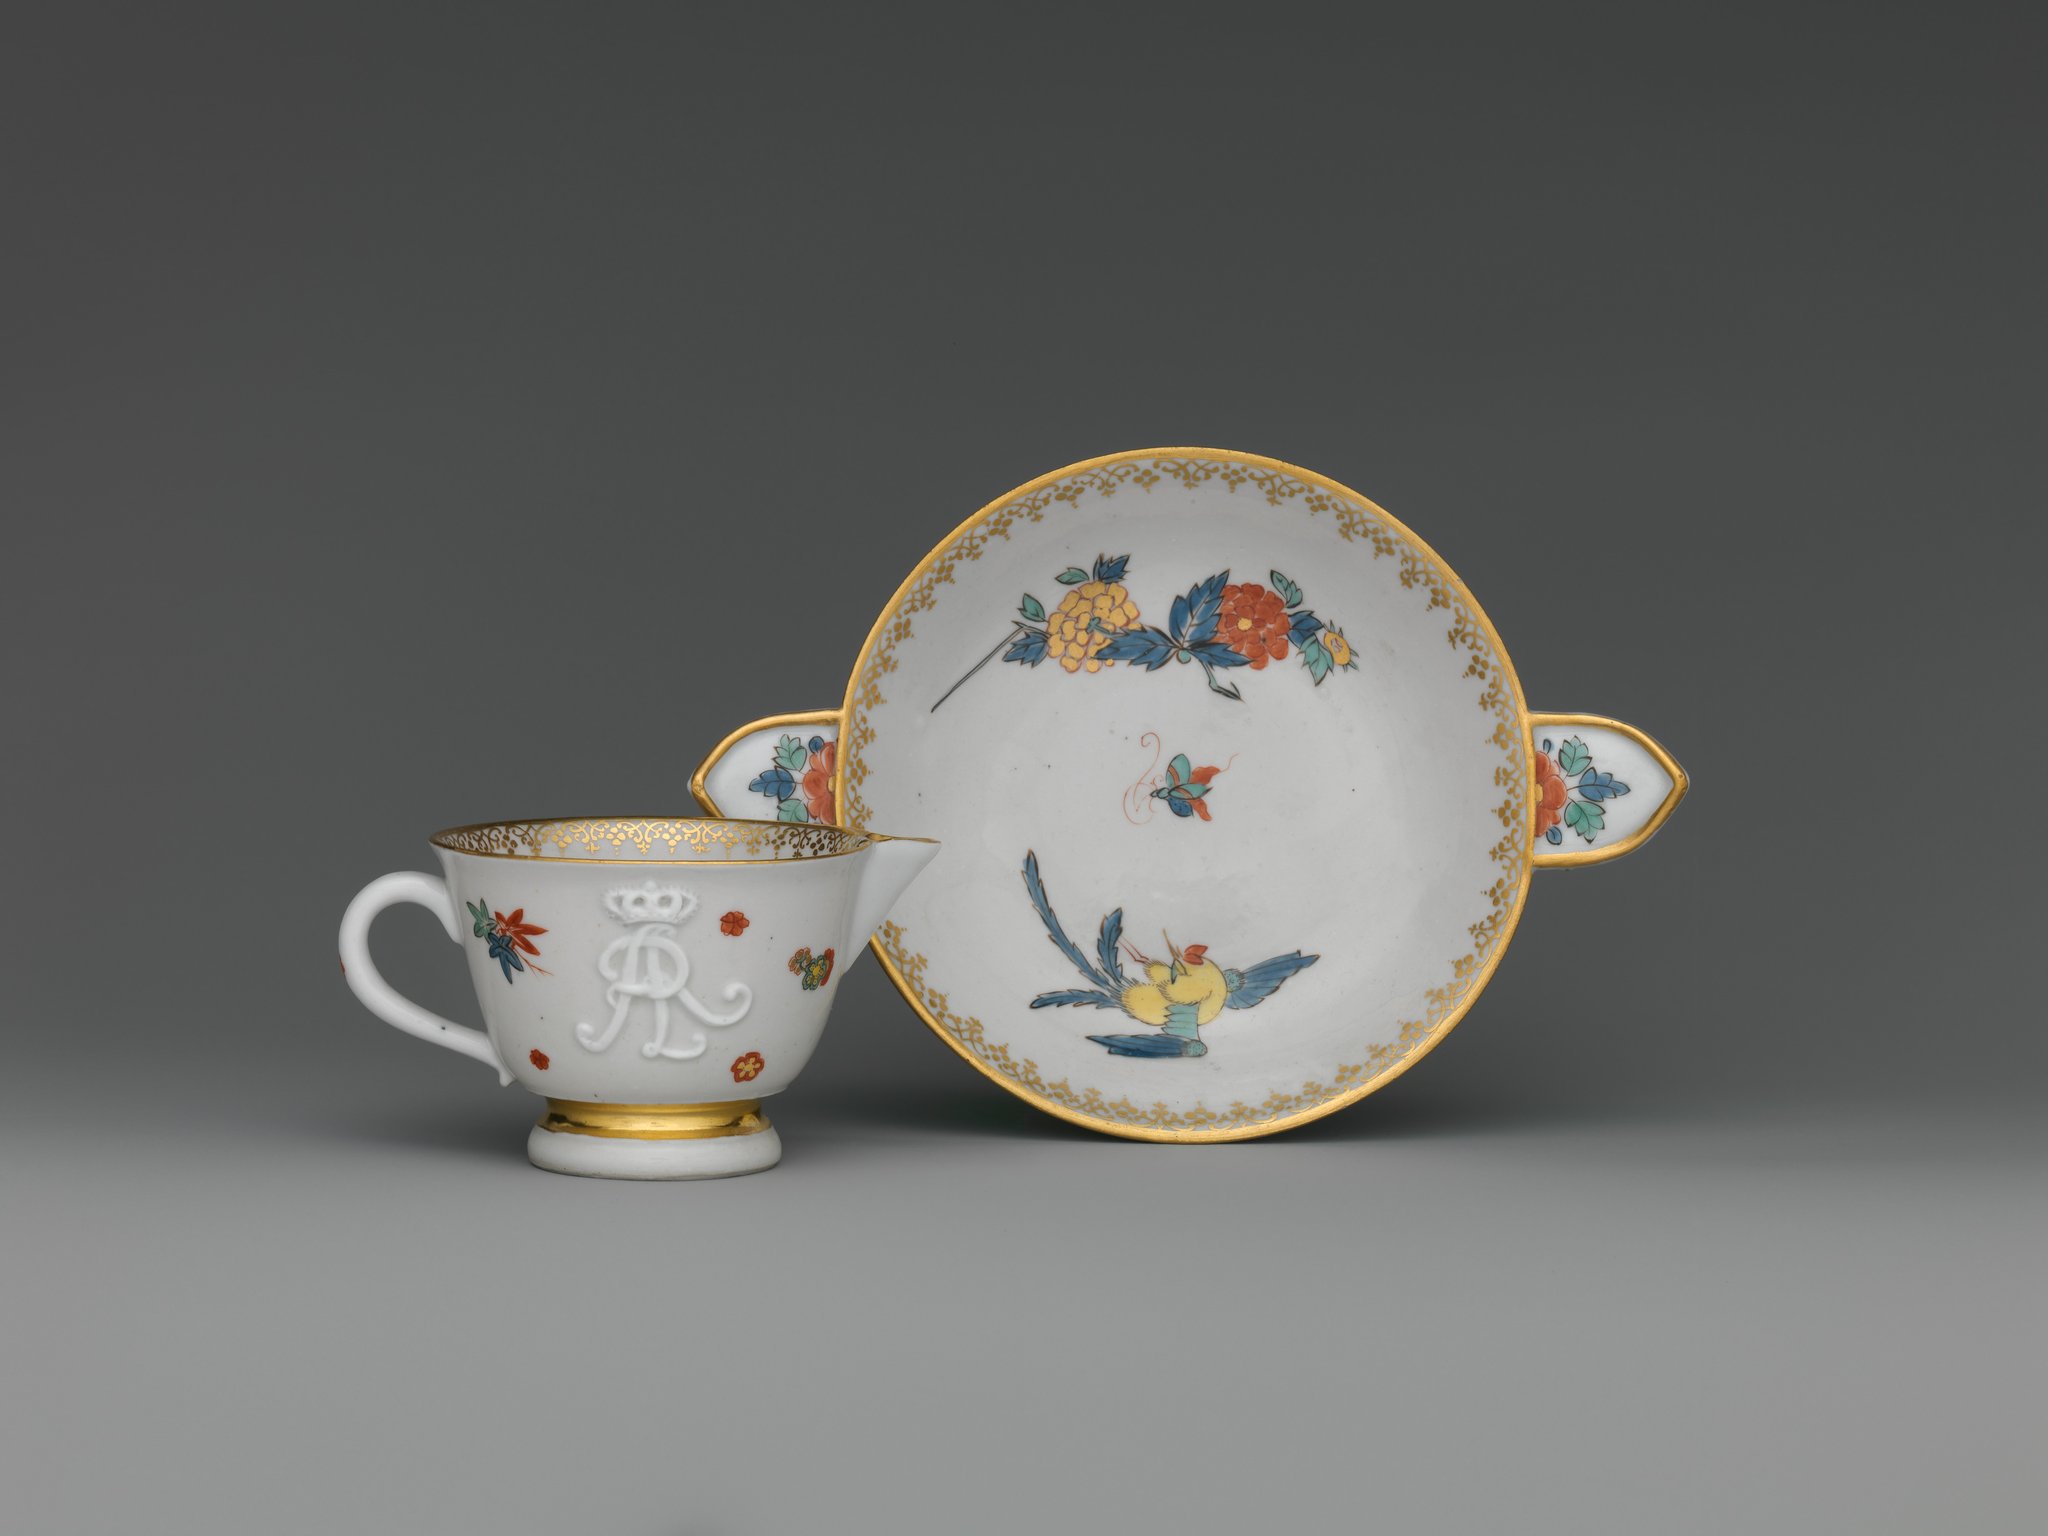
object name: pitcher and stand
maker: meissen manufactory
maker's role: manufactory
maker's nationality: german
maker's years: 1710-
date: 1725-1730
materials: hard paste porcelain